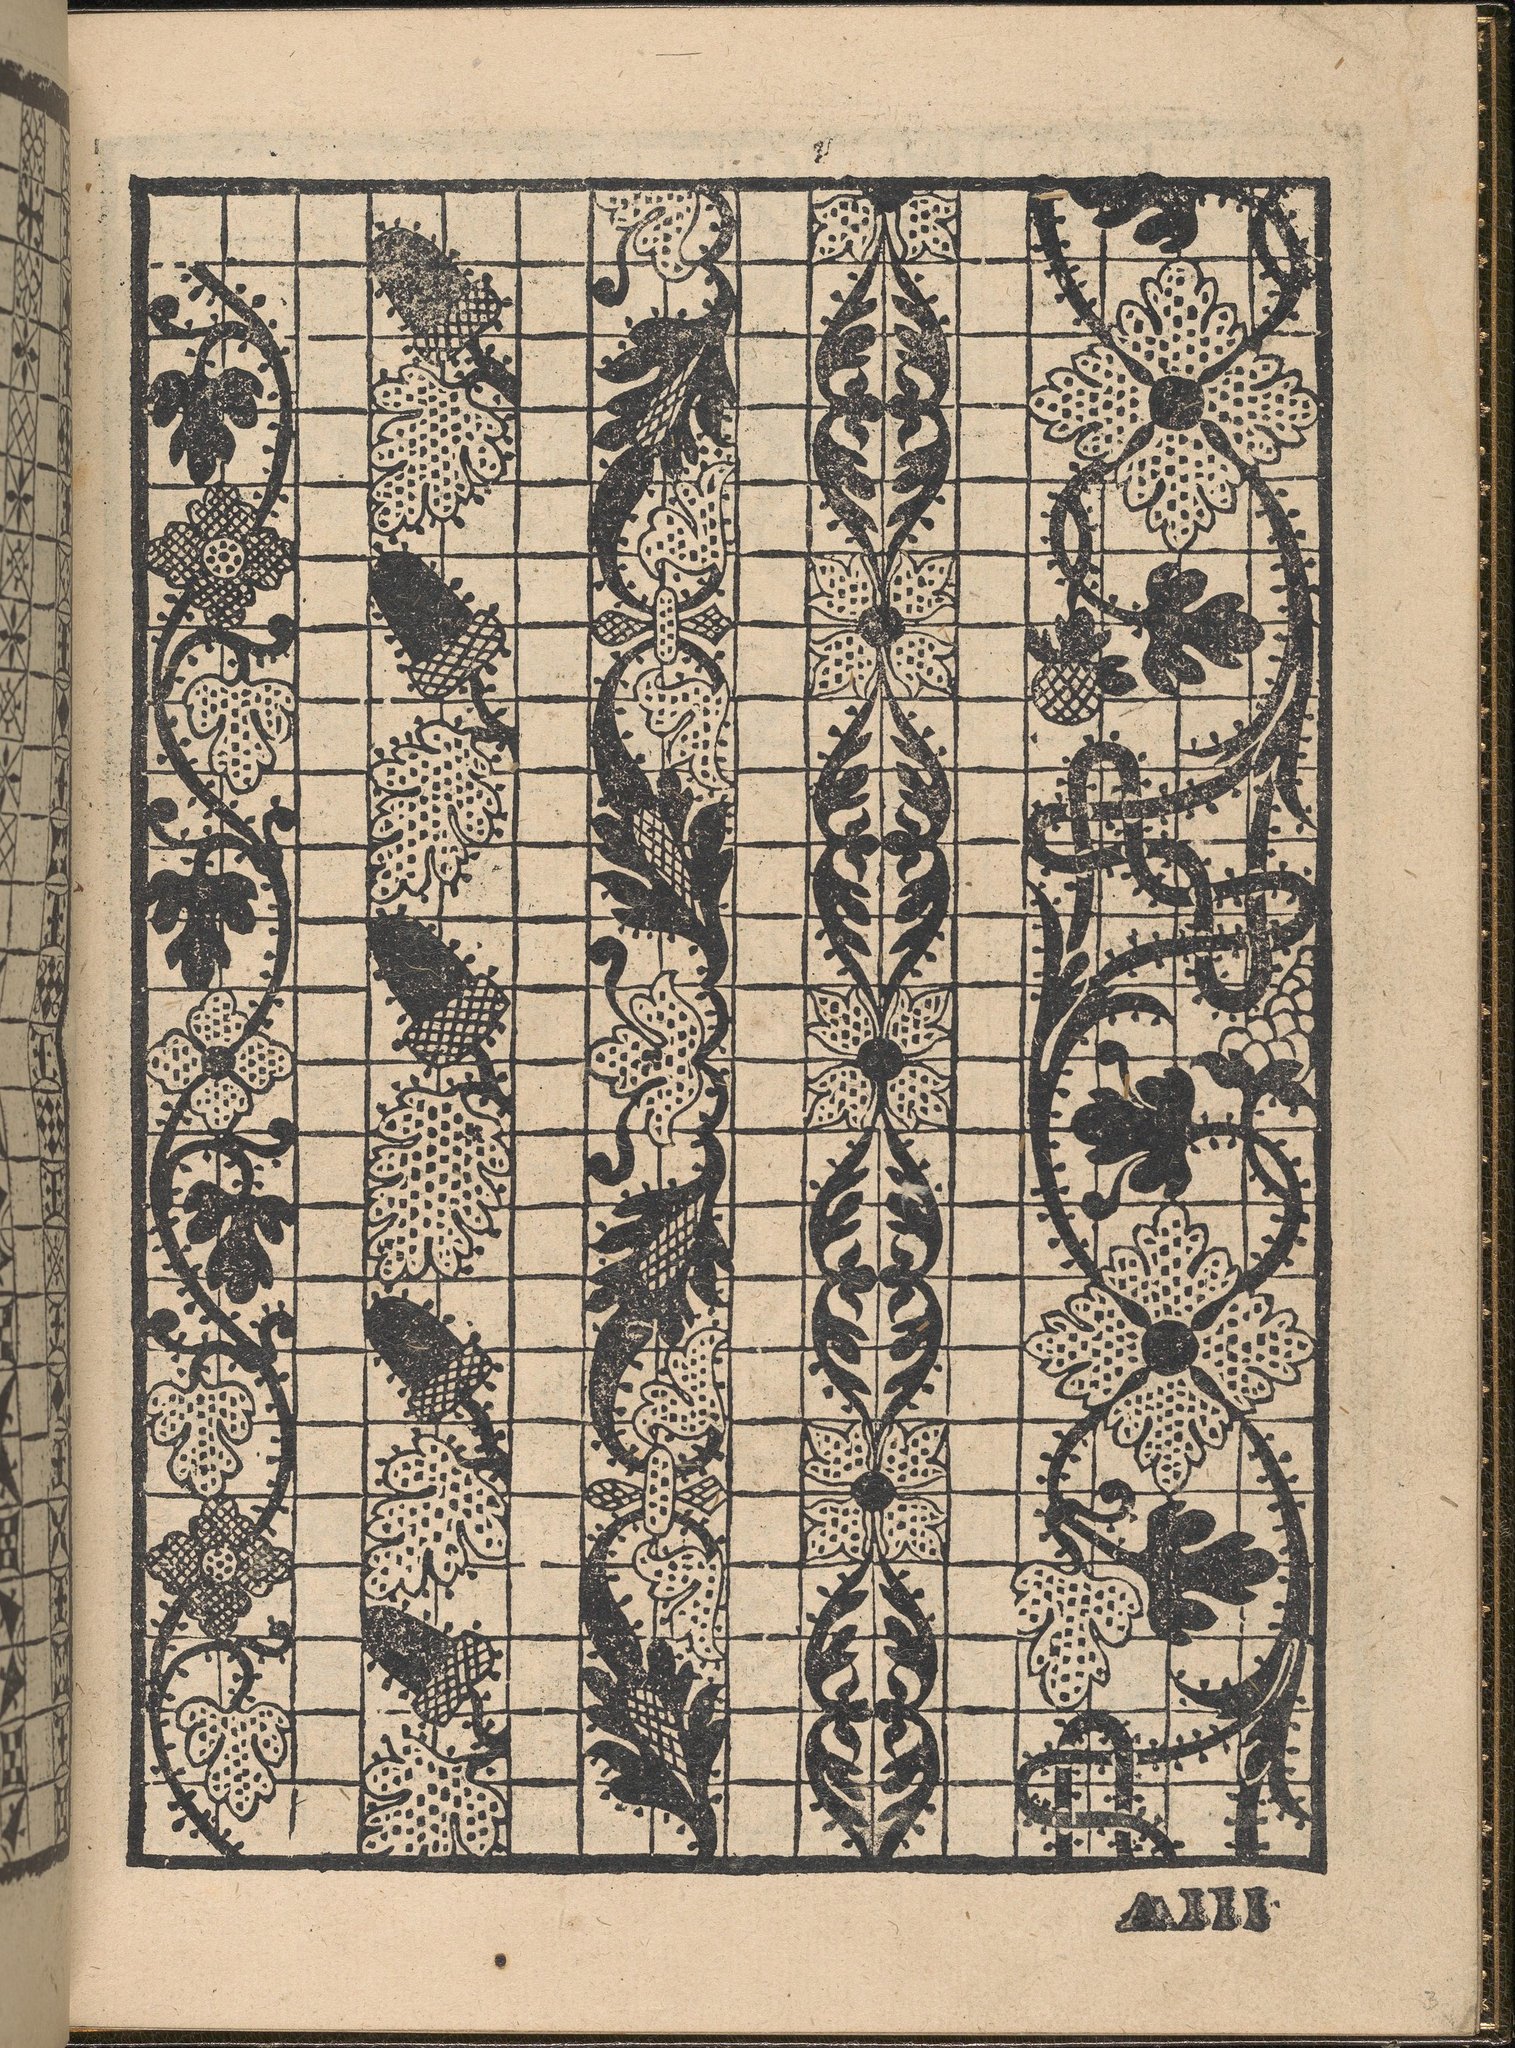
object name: book print ornament architecture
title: La Gloria et l'Honore di Ponti Tagliati, E Ponti in Aere, page 2 (verso)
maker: matteo pagano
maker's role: publisher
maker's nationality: italian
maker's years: 1515-1588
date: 1556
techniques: woodcut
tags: ornament